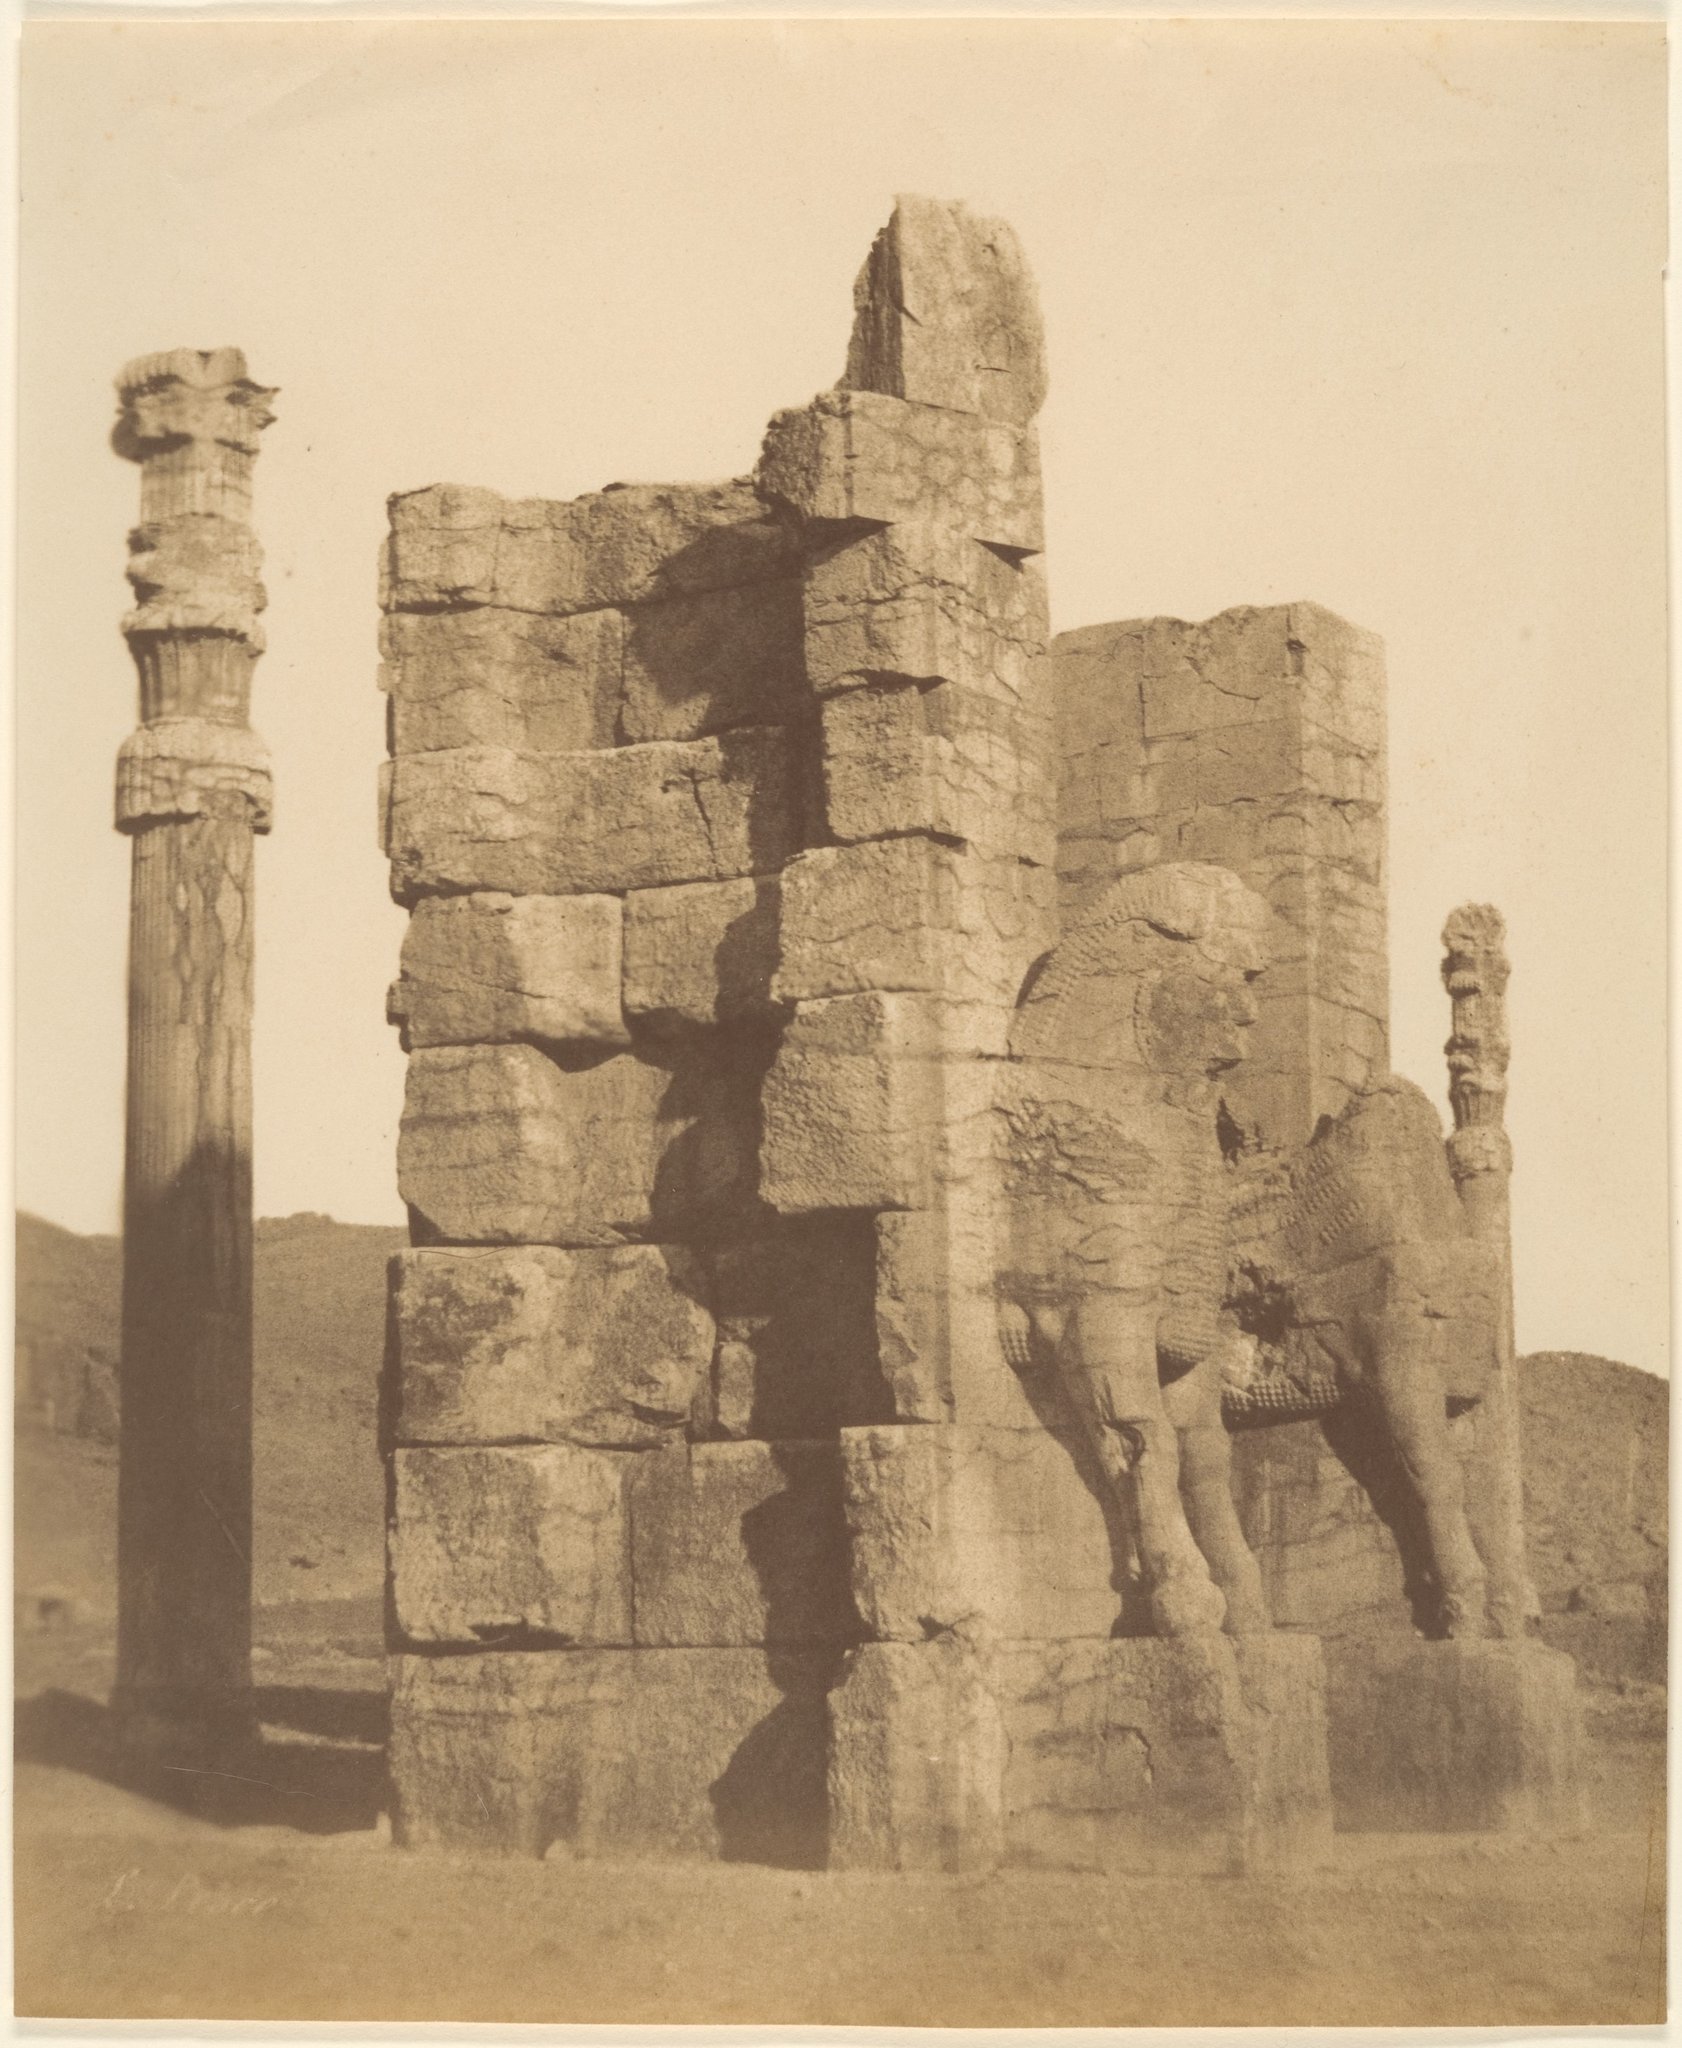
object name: photograph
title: (10) [Gate of all Nations, Persepolis, Fars]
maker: luigi pesce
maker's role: artist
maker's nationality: italian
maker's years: 1818-1891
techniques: albumen silver print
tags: gates,ruins